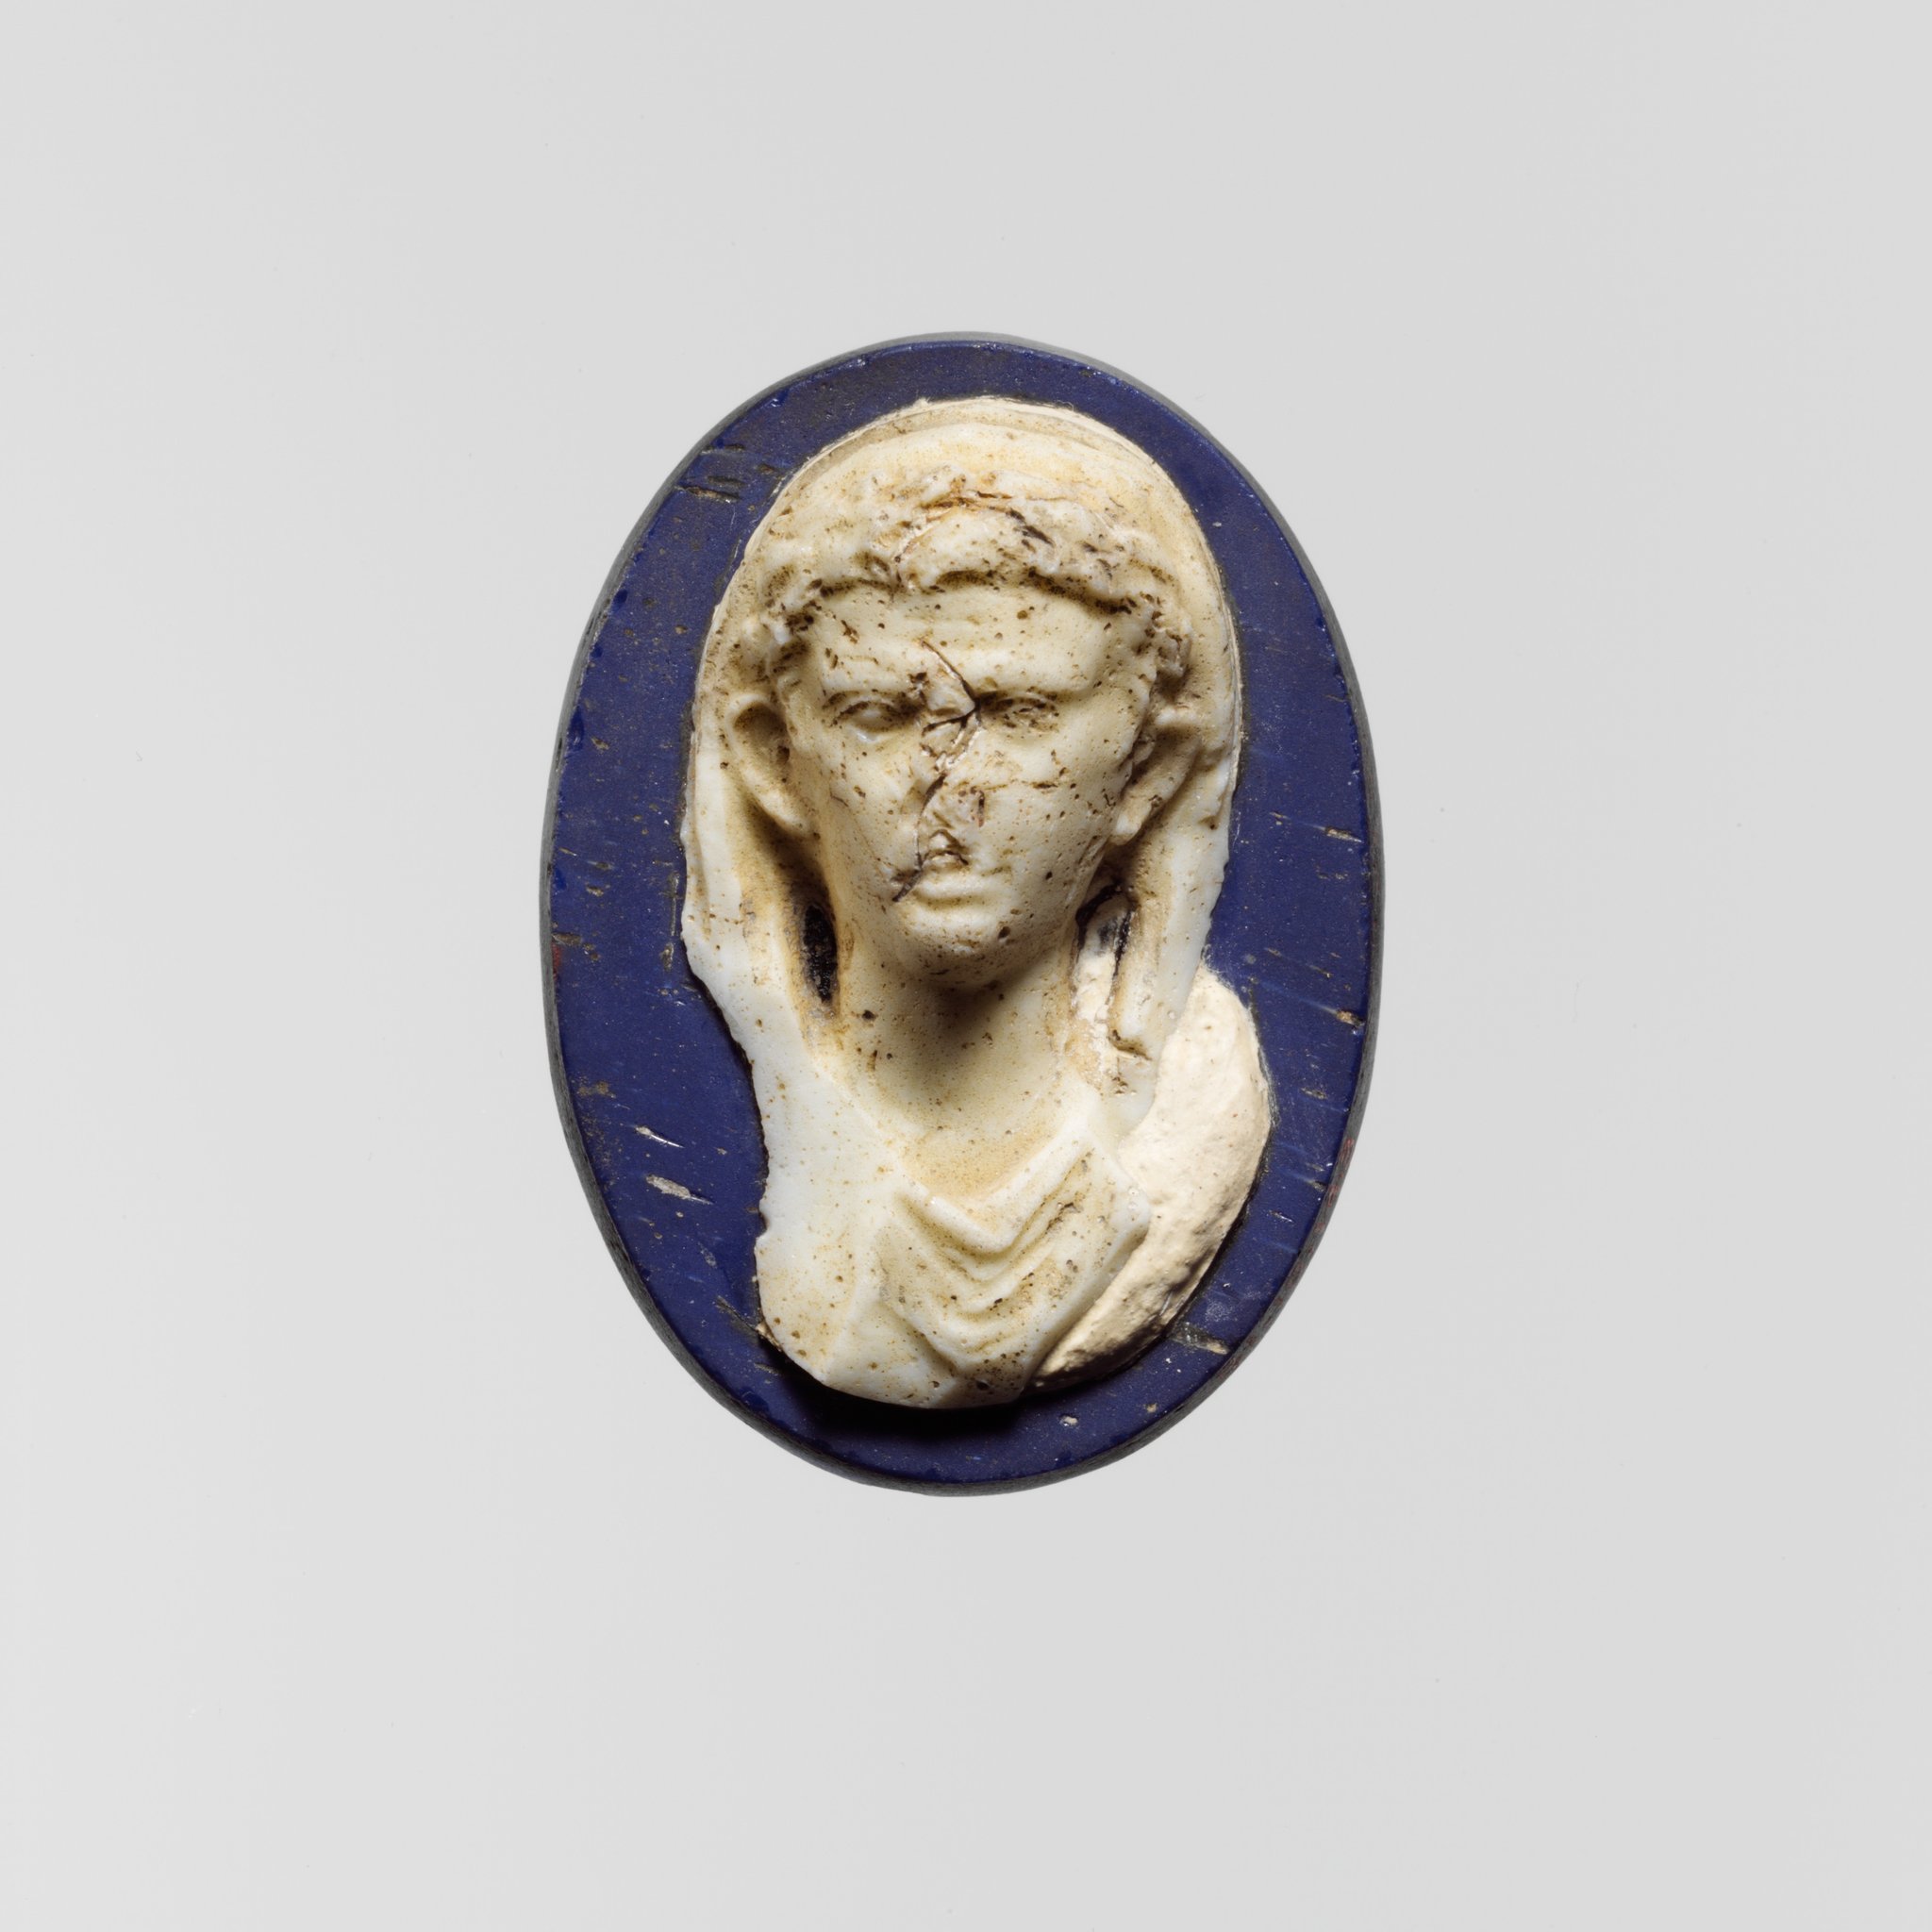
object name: cameo medallion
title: Cameo glass medallion of the emperor Augustus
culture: roman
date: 1-33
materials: glass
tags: emperor augustus,heads,men